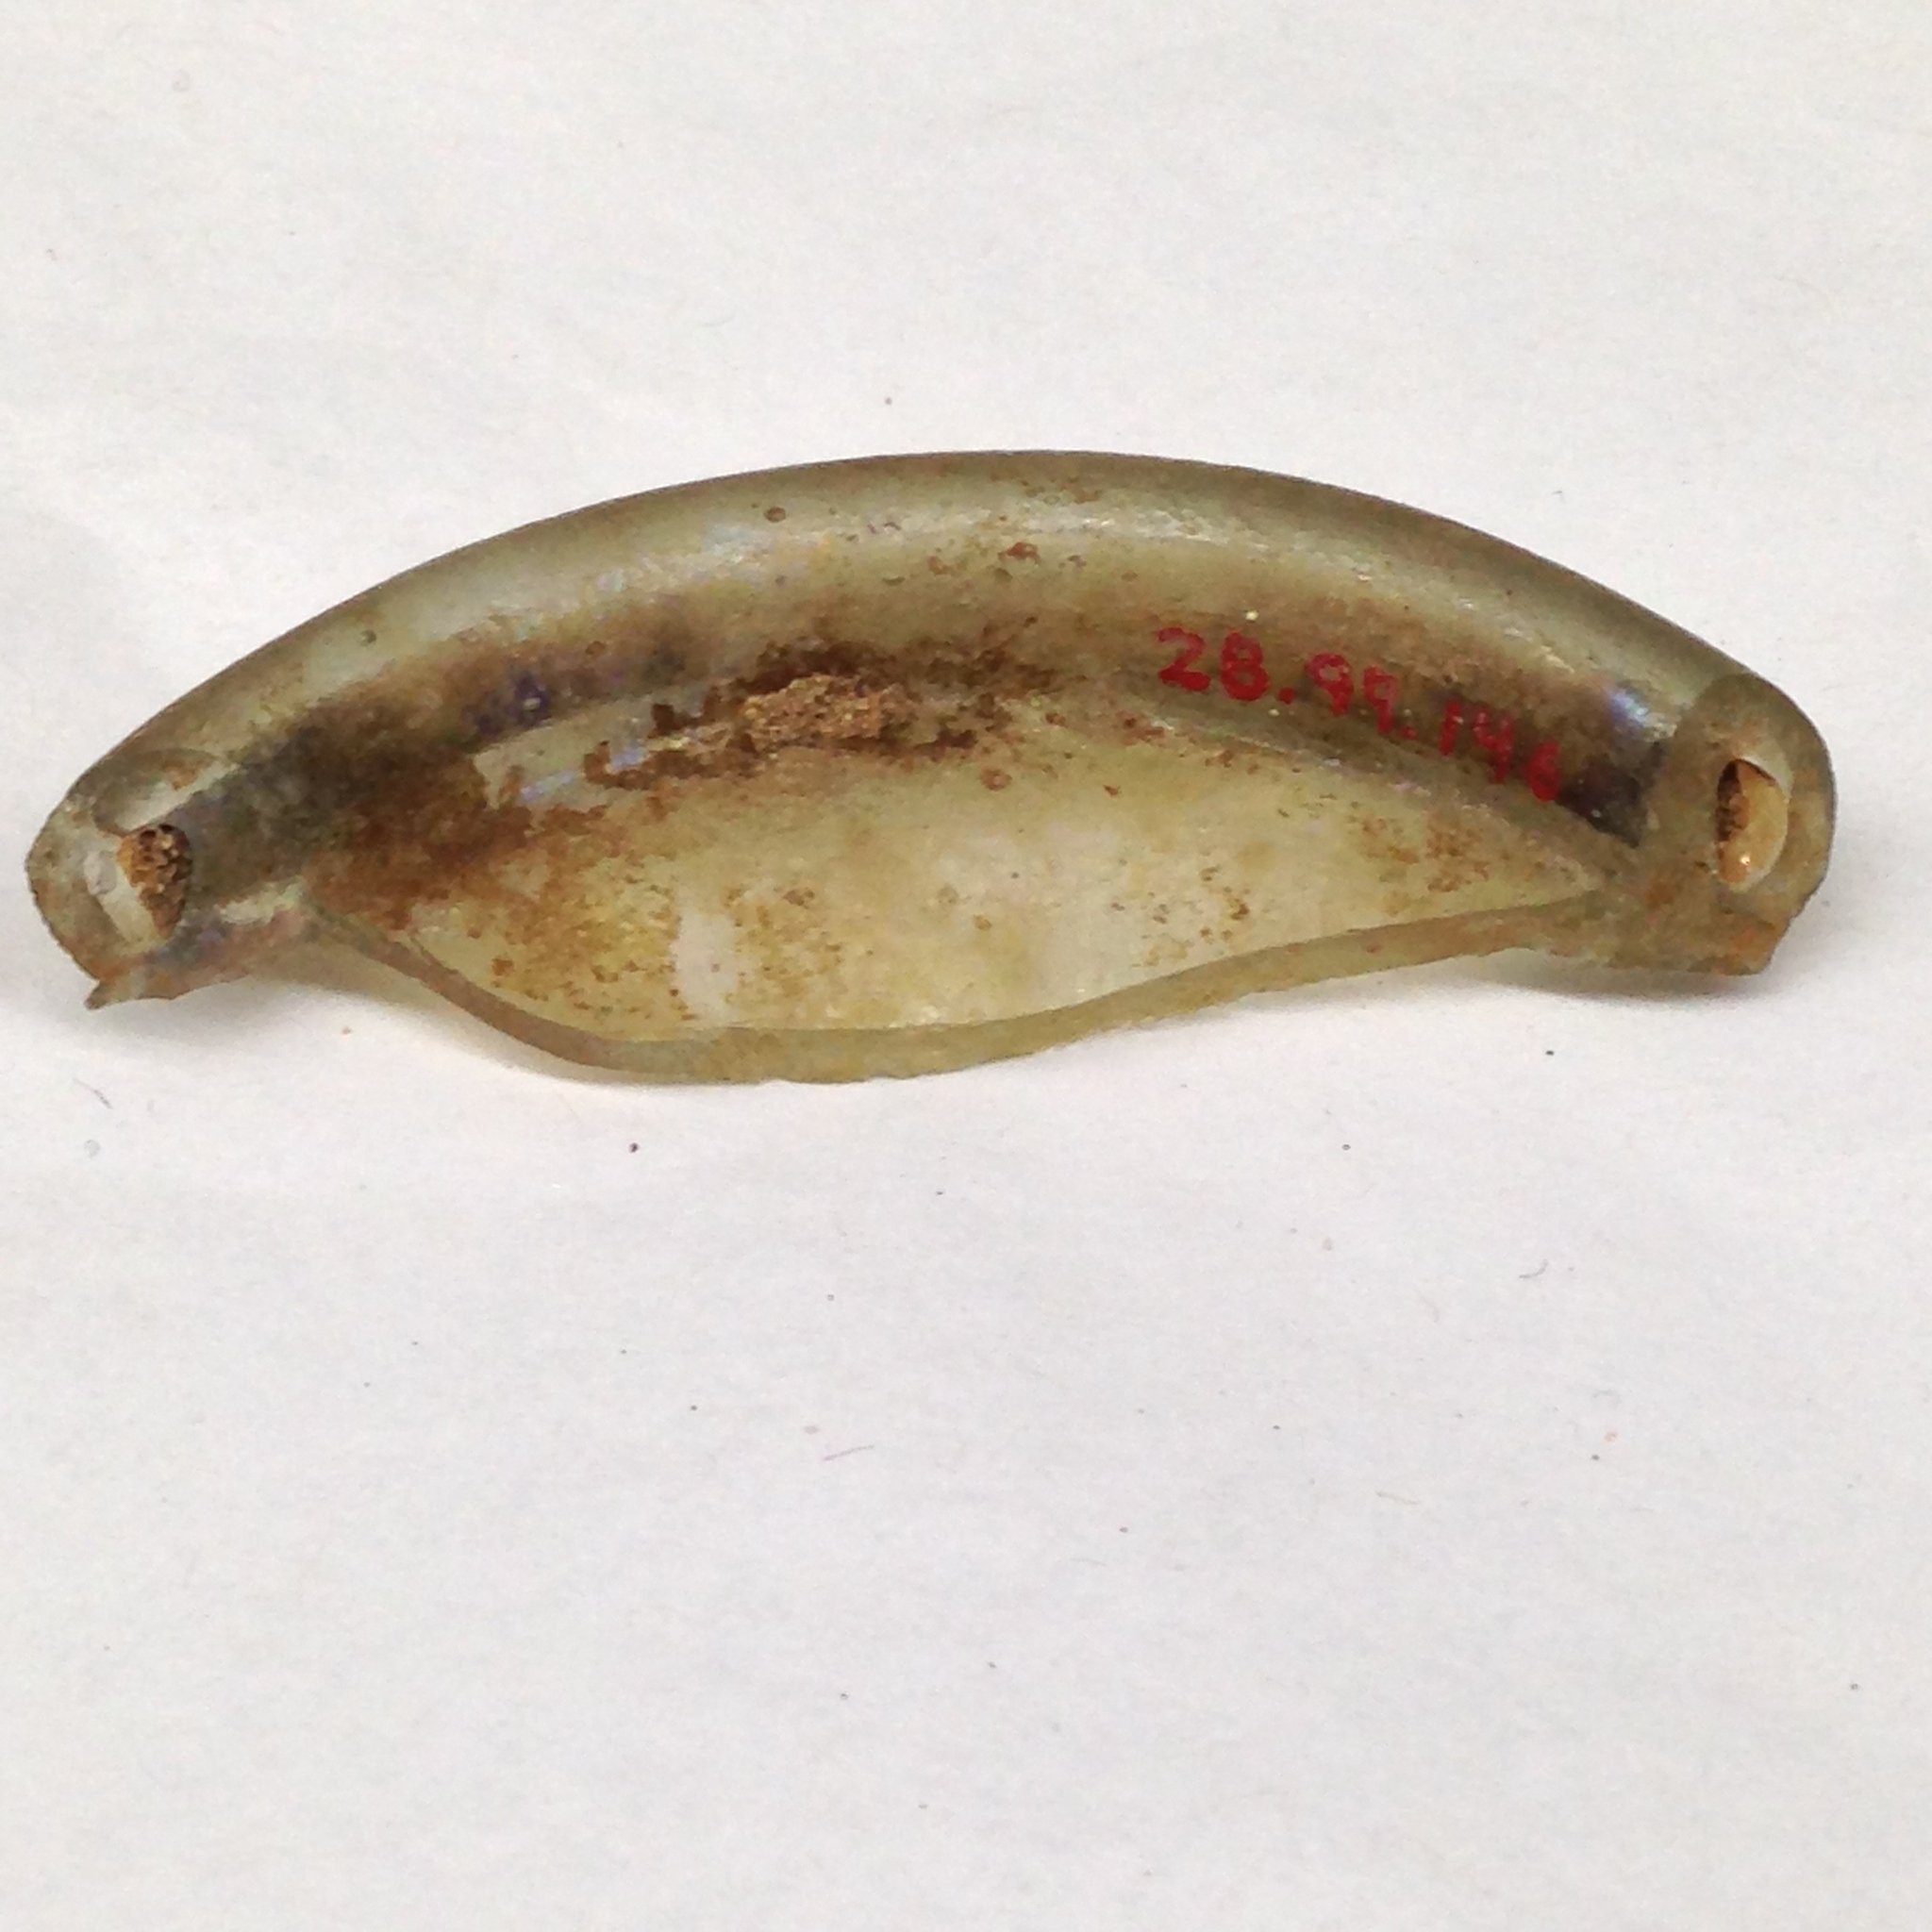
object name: fragment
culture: european or middle eastern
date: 1150-1250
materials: ceramic, glass